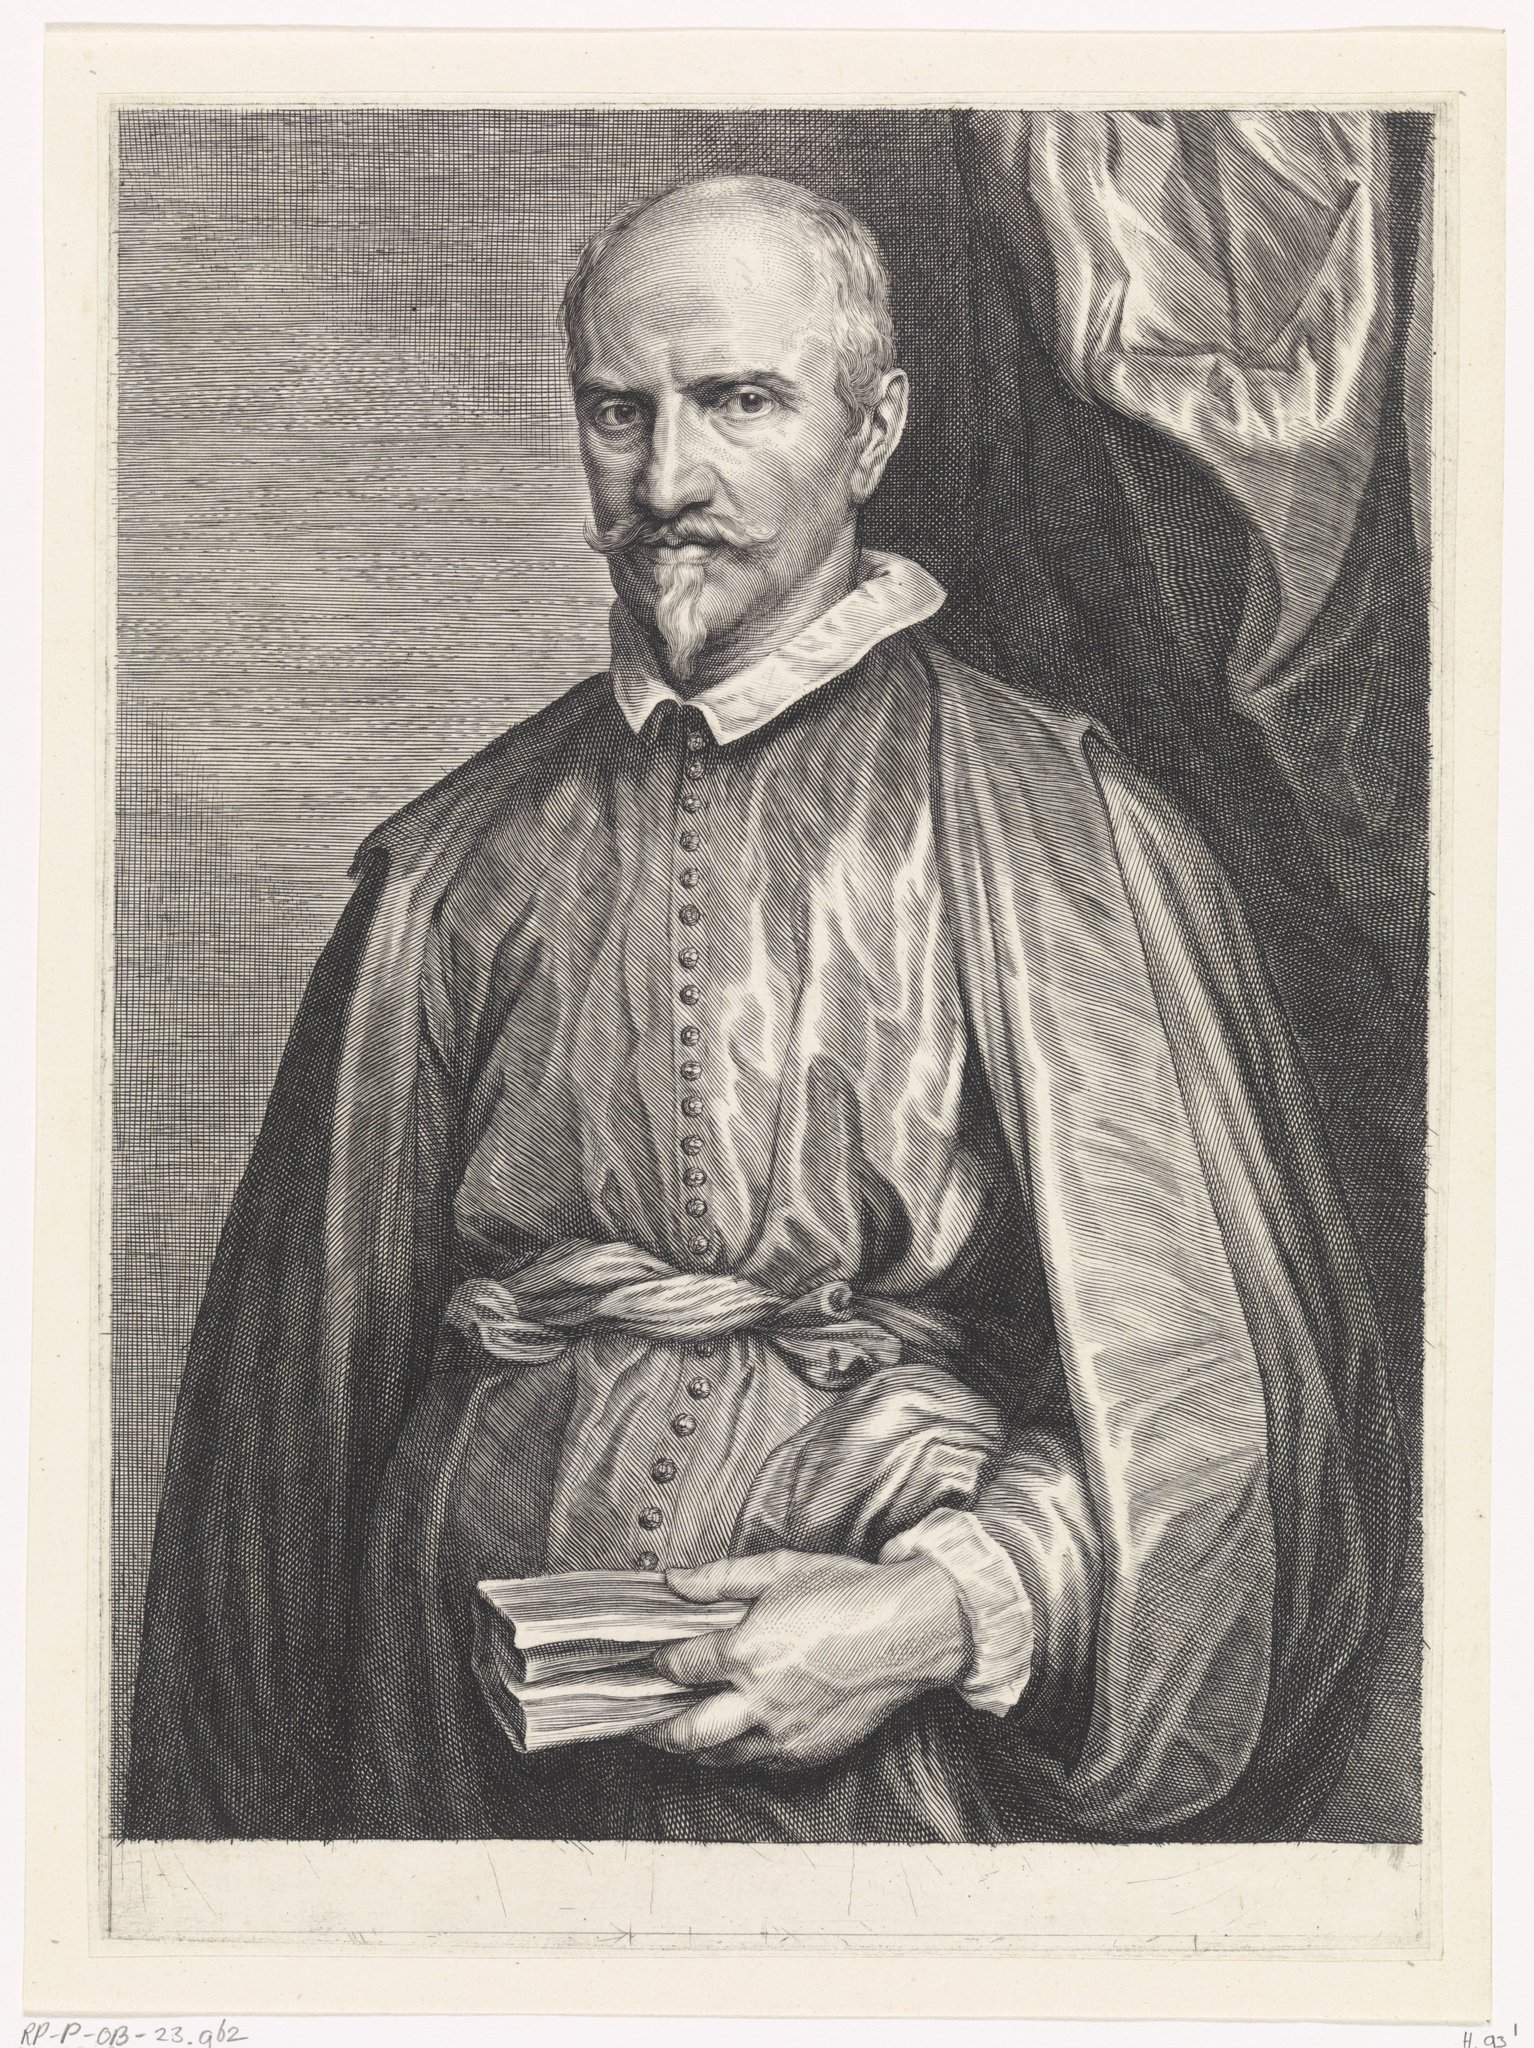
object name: print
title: Portret van Antonio de Tassis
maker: jacob neefs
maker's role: print maker, publisher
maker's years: 1610-1660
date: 1626-1680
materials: paper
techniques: engraving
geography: antwerp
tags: antwerp, antonio de tassis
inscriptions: collector's mark: Lugt 2228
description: Antonio de Tassis, staande en gekleed in een wijde mantel, met in zijn rechterhand een boek. Portret ten halven lijve naar links.